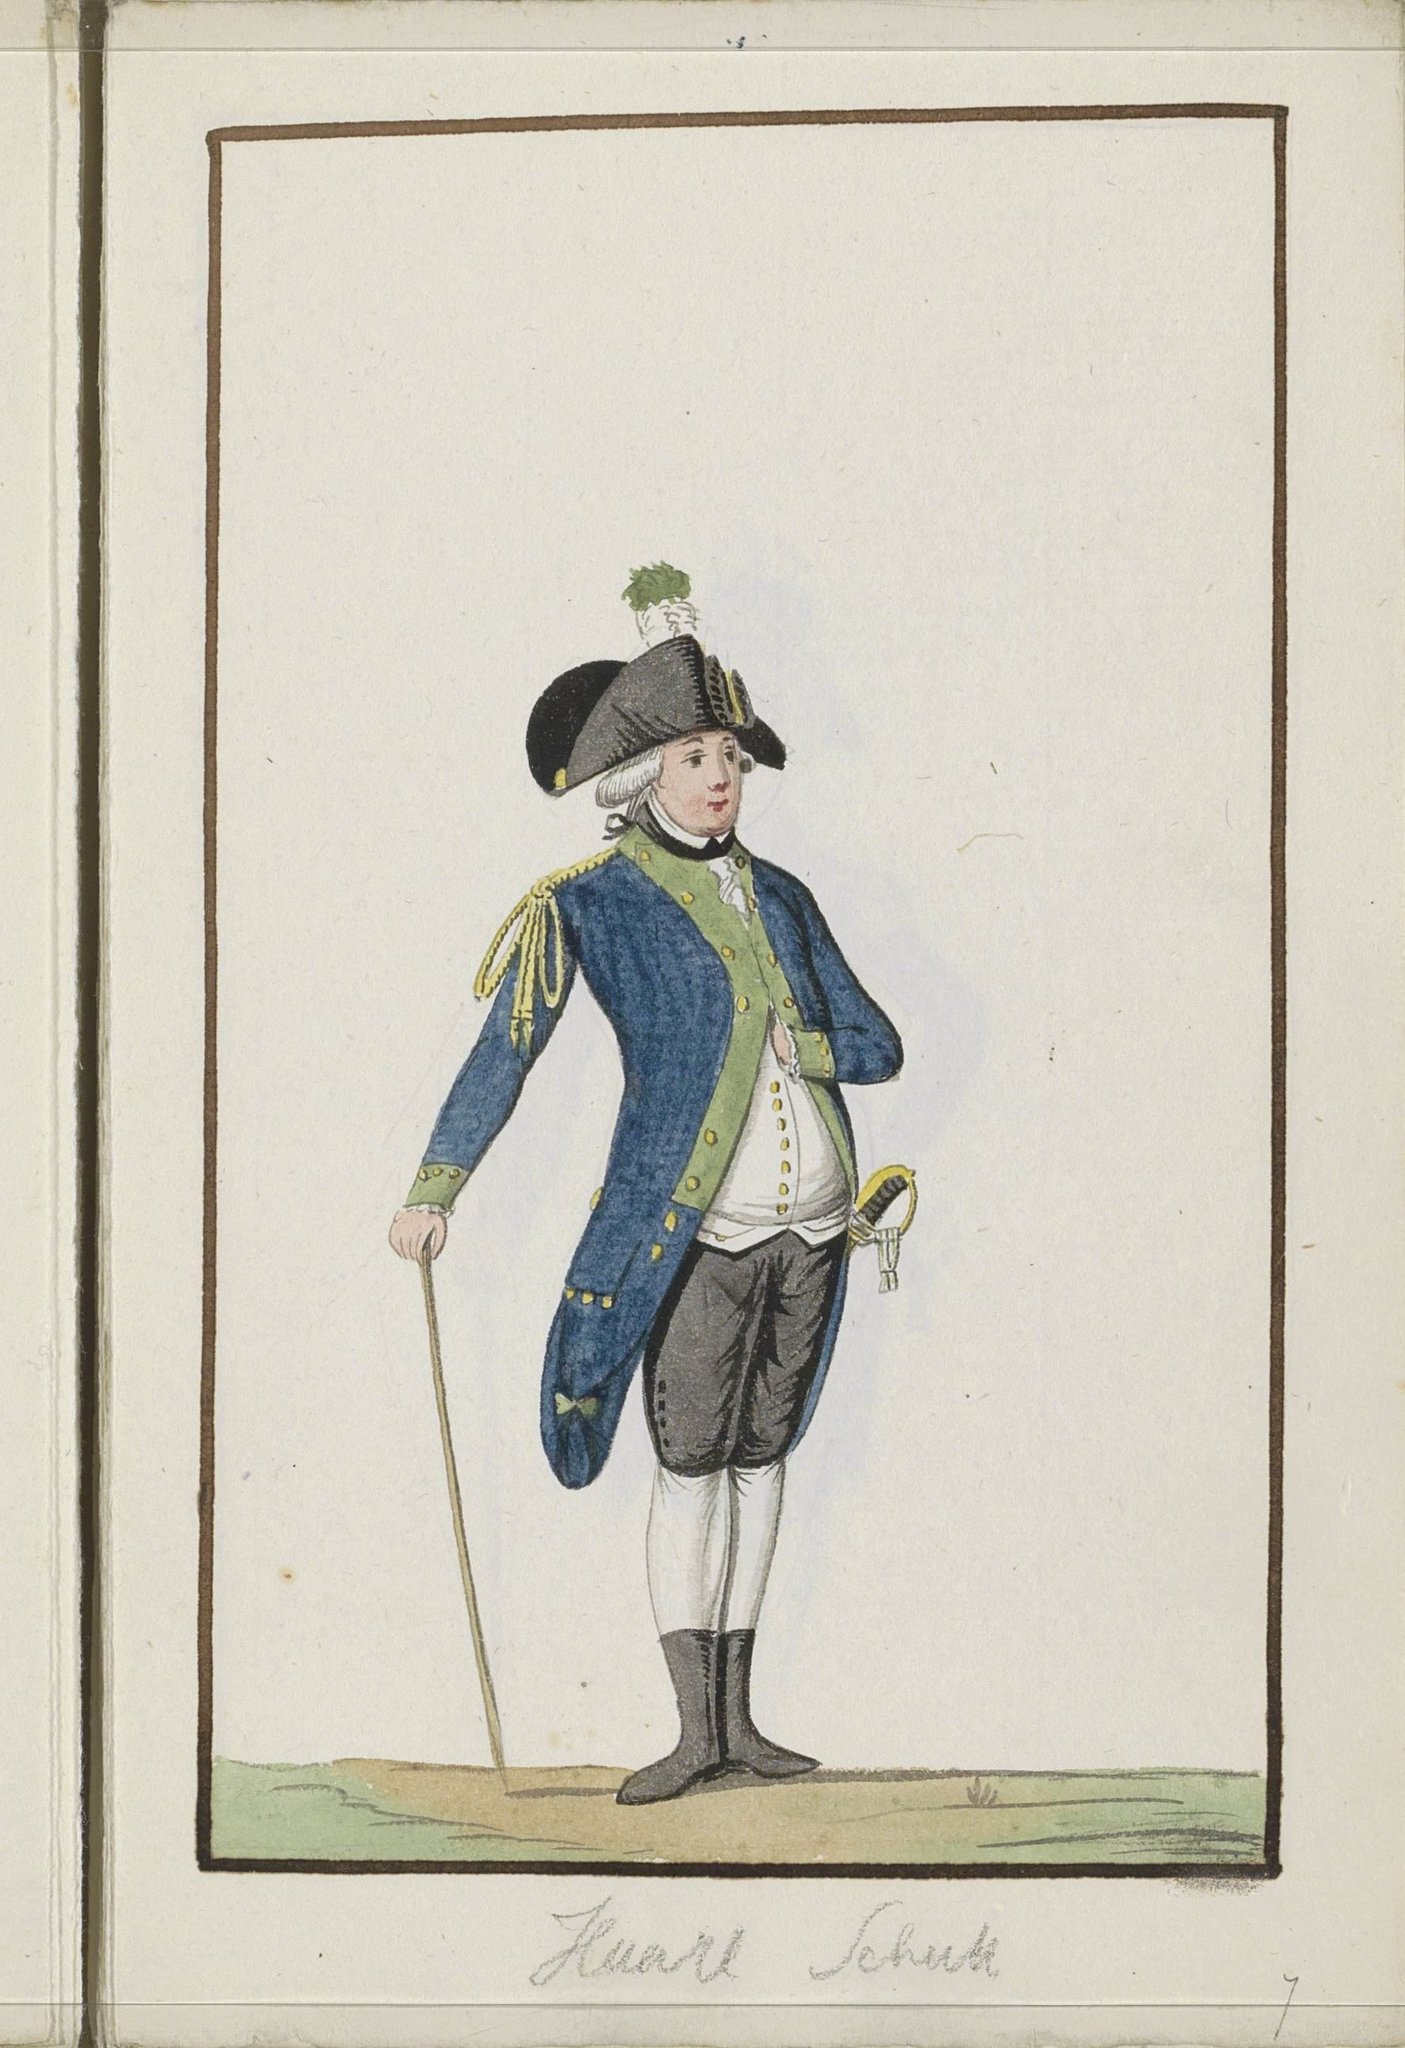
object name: costume print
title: Haarlem Schuttery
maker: Anonymous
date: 1789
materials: paper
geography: northern netherlands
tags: (military) uniforms (+ citizen soldiery, civil guard, citizen militia), haarlem, patriots (1780-1795)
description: Montering of uniform van de Haarlemse schutterij, ca. 1785. Onderdeel van een schetsboek met 41 gekleurde tekeningen van de monteringen van de gewapende schutterijen en burgercorpsen in Nederland in de periode ca. 1783-1789.